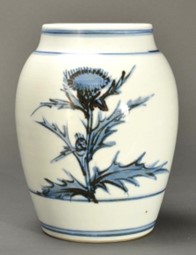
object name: jar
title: Jar with Thistle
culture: japanese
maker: kondō yūzō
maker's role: artist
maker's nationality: japanese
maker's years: 1902-1985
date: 1950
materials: cobalt, porcelain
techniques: underglaze